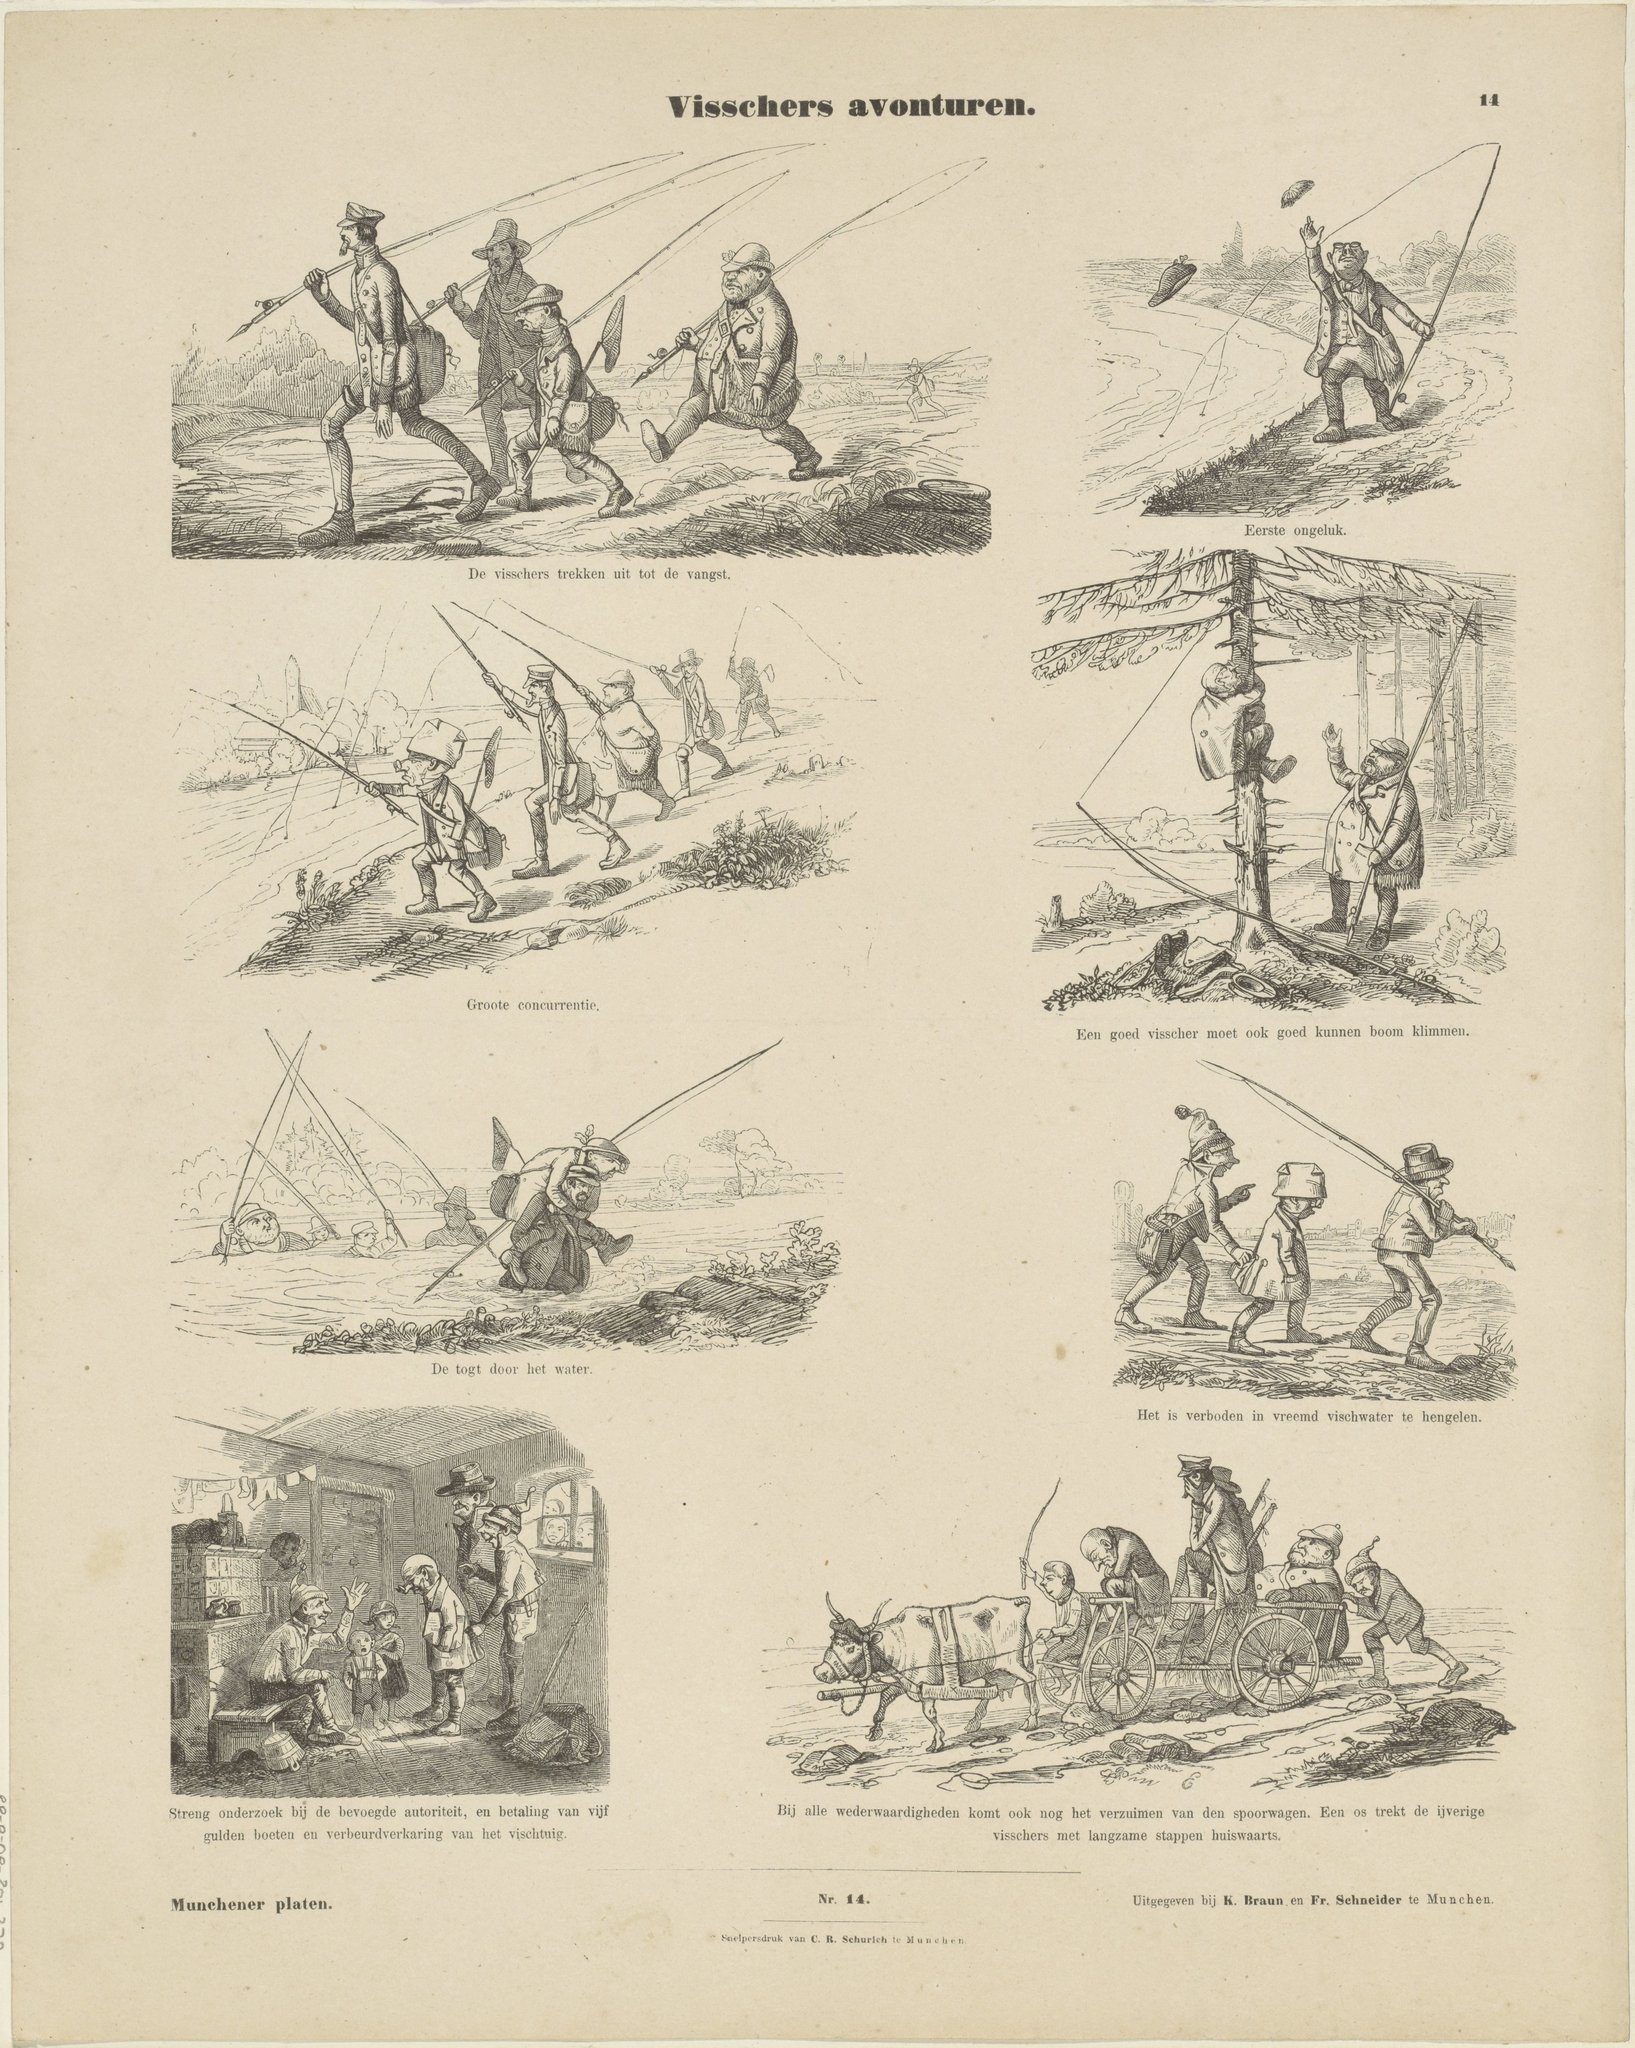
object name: print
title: Visschers avonturen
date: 1843-1920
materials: paper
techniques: letterpress printing, engraving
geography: munich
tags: commercial fishery, fisherman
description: Blad met 8 voorstellingen van vissers. Onder elke afbeelding een onderschrift. Genummerd midden onder: Nr. 14. Genummerd rechtsboven: 14.